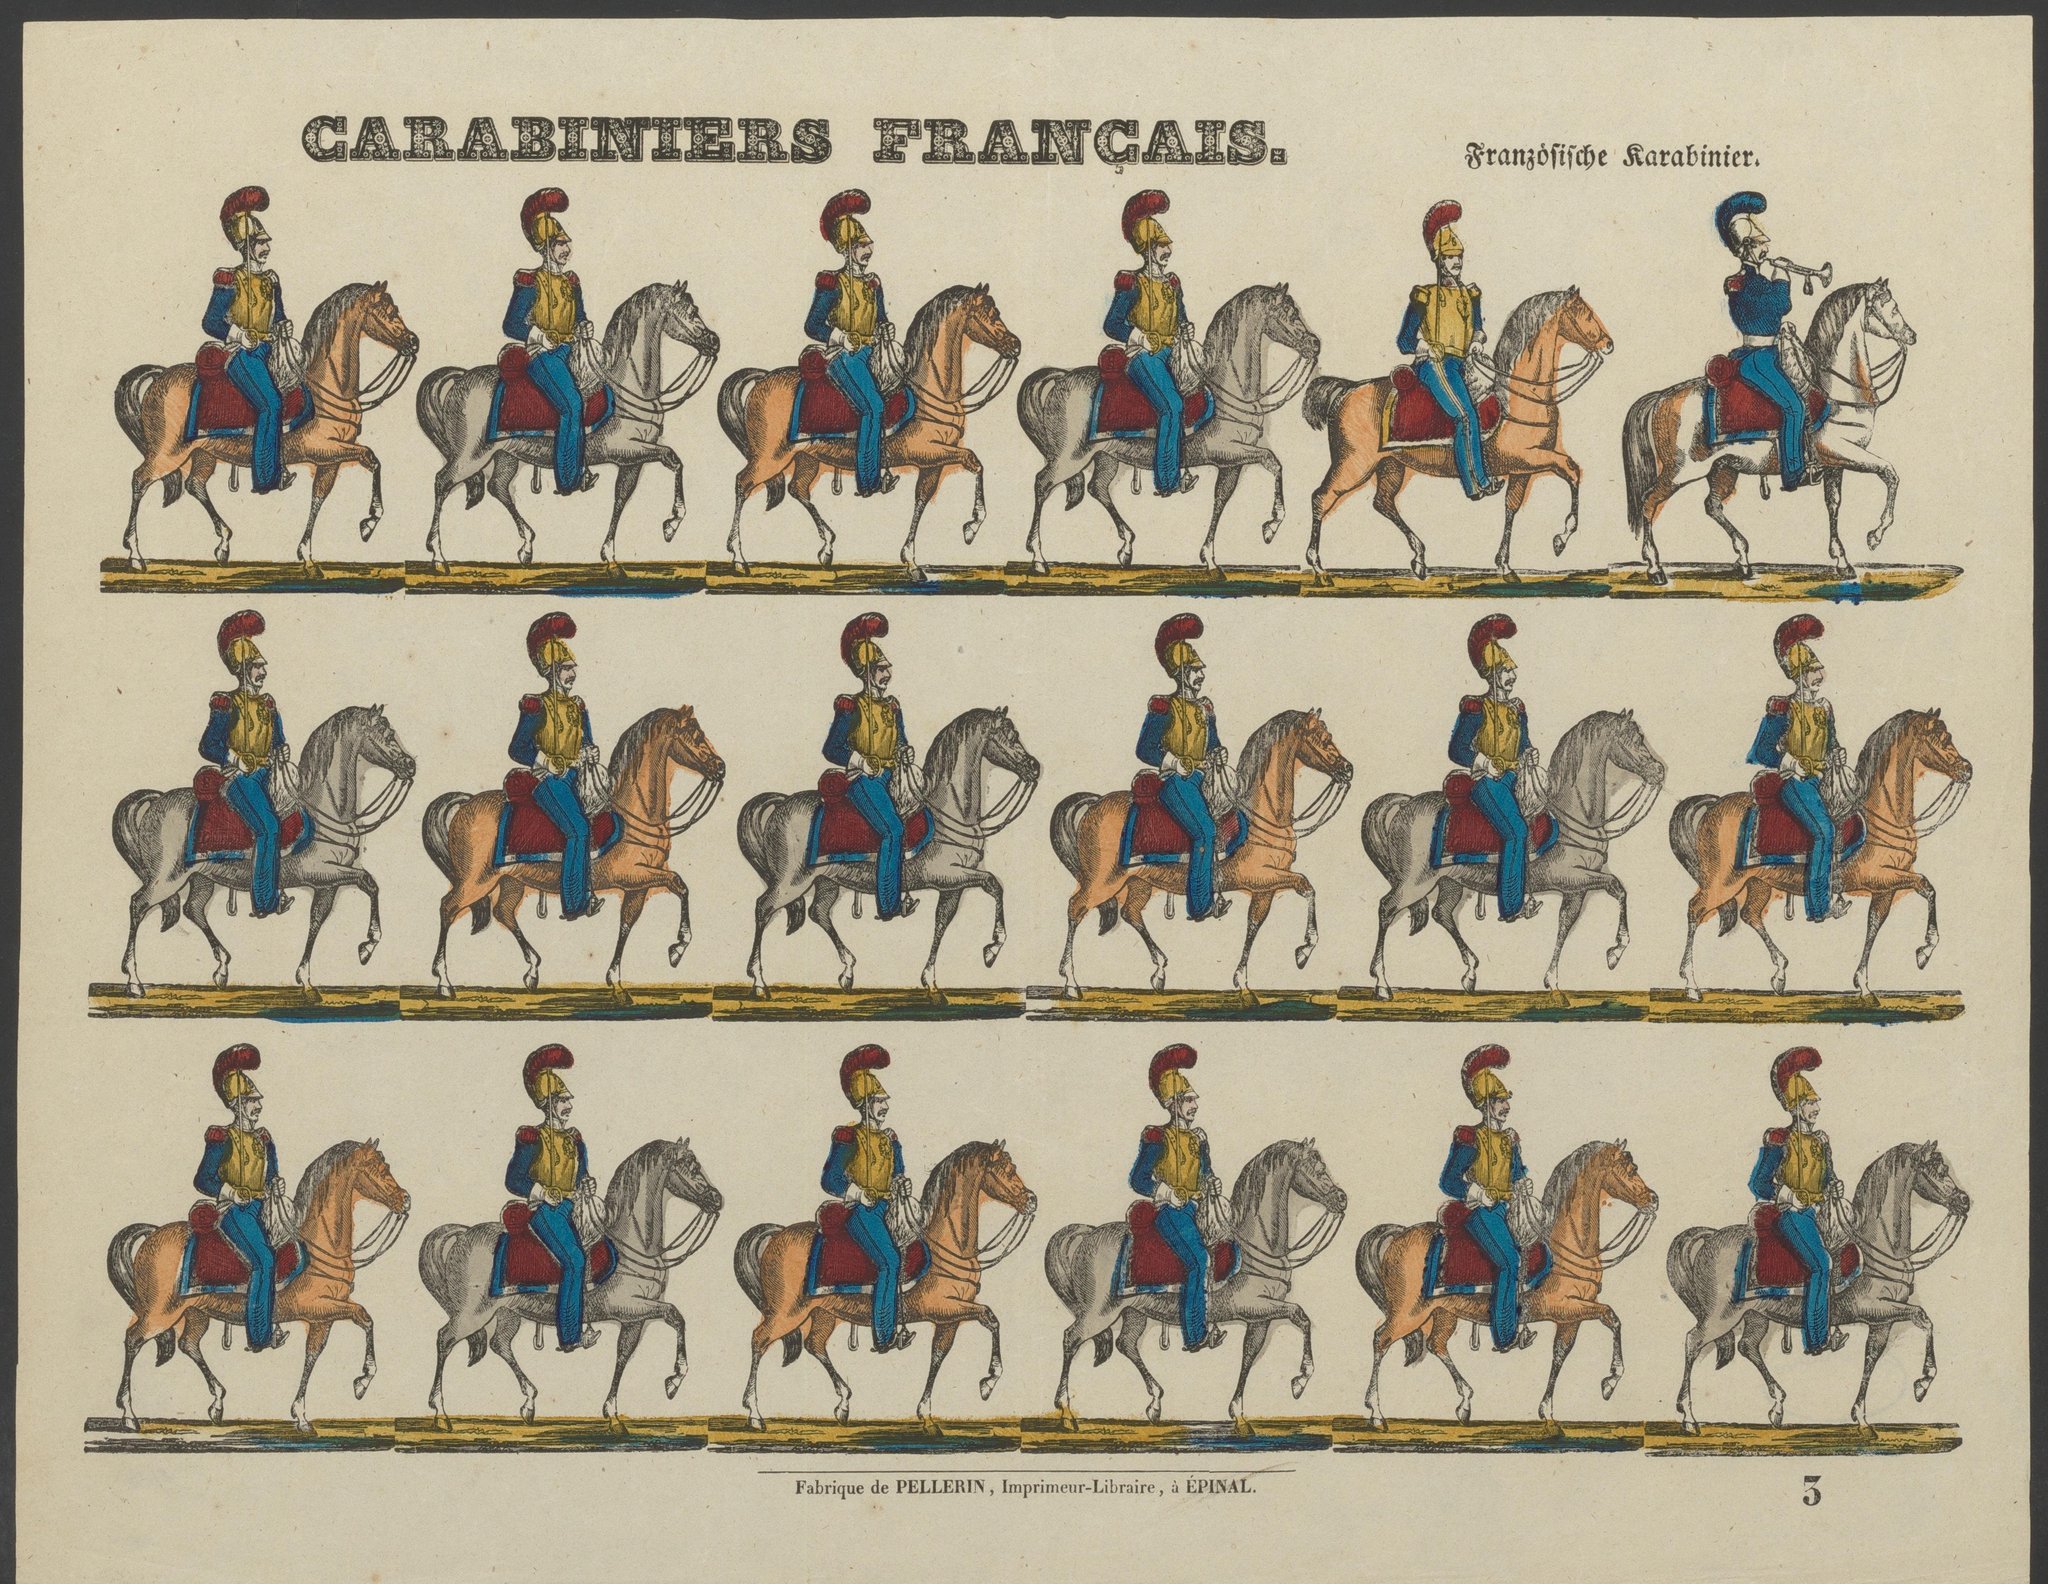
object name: print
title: Franse Karabinier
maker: Anonymous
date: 1791-1900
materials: paper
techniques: hand coloring, lithograph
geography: epinal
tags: the company, the unit, the troop ~ military service, private soldier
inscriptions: stamp, collector's mark: Lugt 1641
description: Rechtsonder genummerd: 3. Onderwerpsrubrieken binnen de Atlas Zeden en Gewoonten: Zeden en Gewoonten in Engeren Zin, Des menschen beging, midden en einde, Kinderleven – Kinderspel en Kinderprenten.